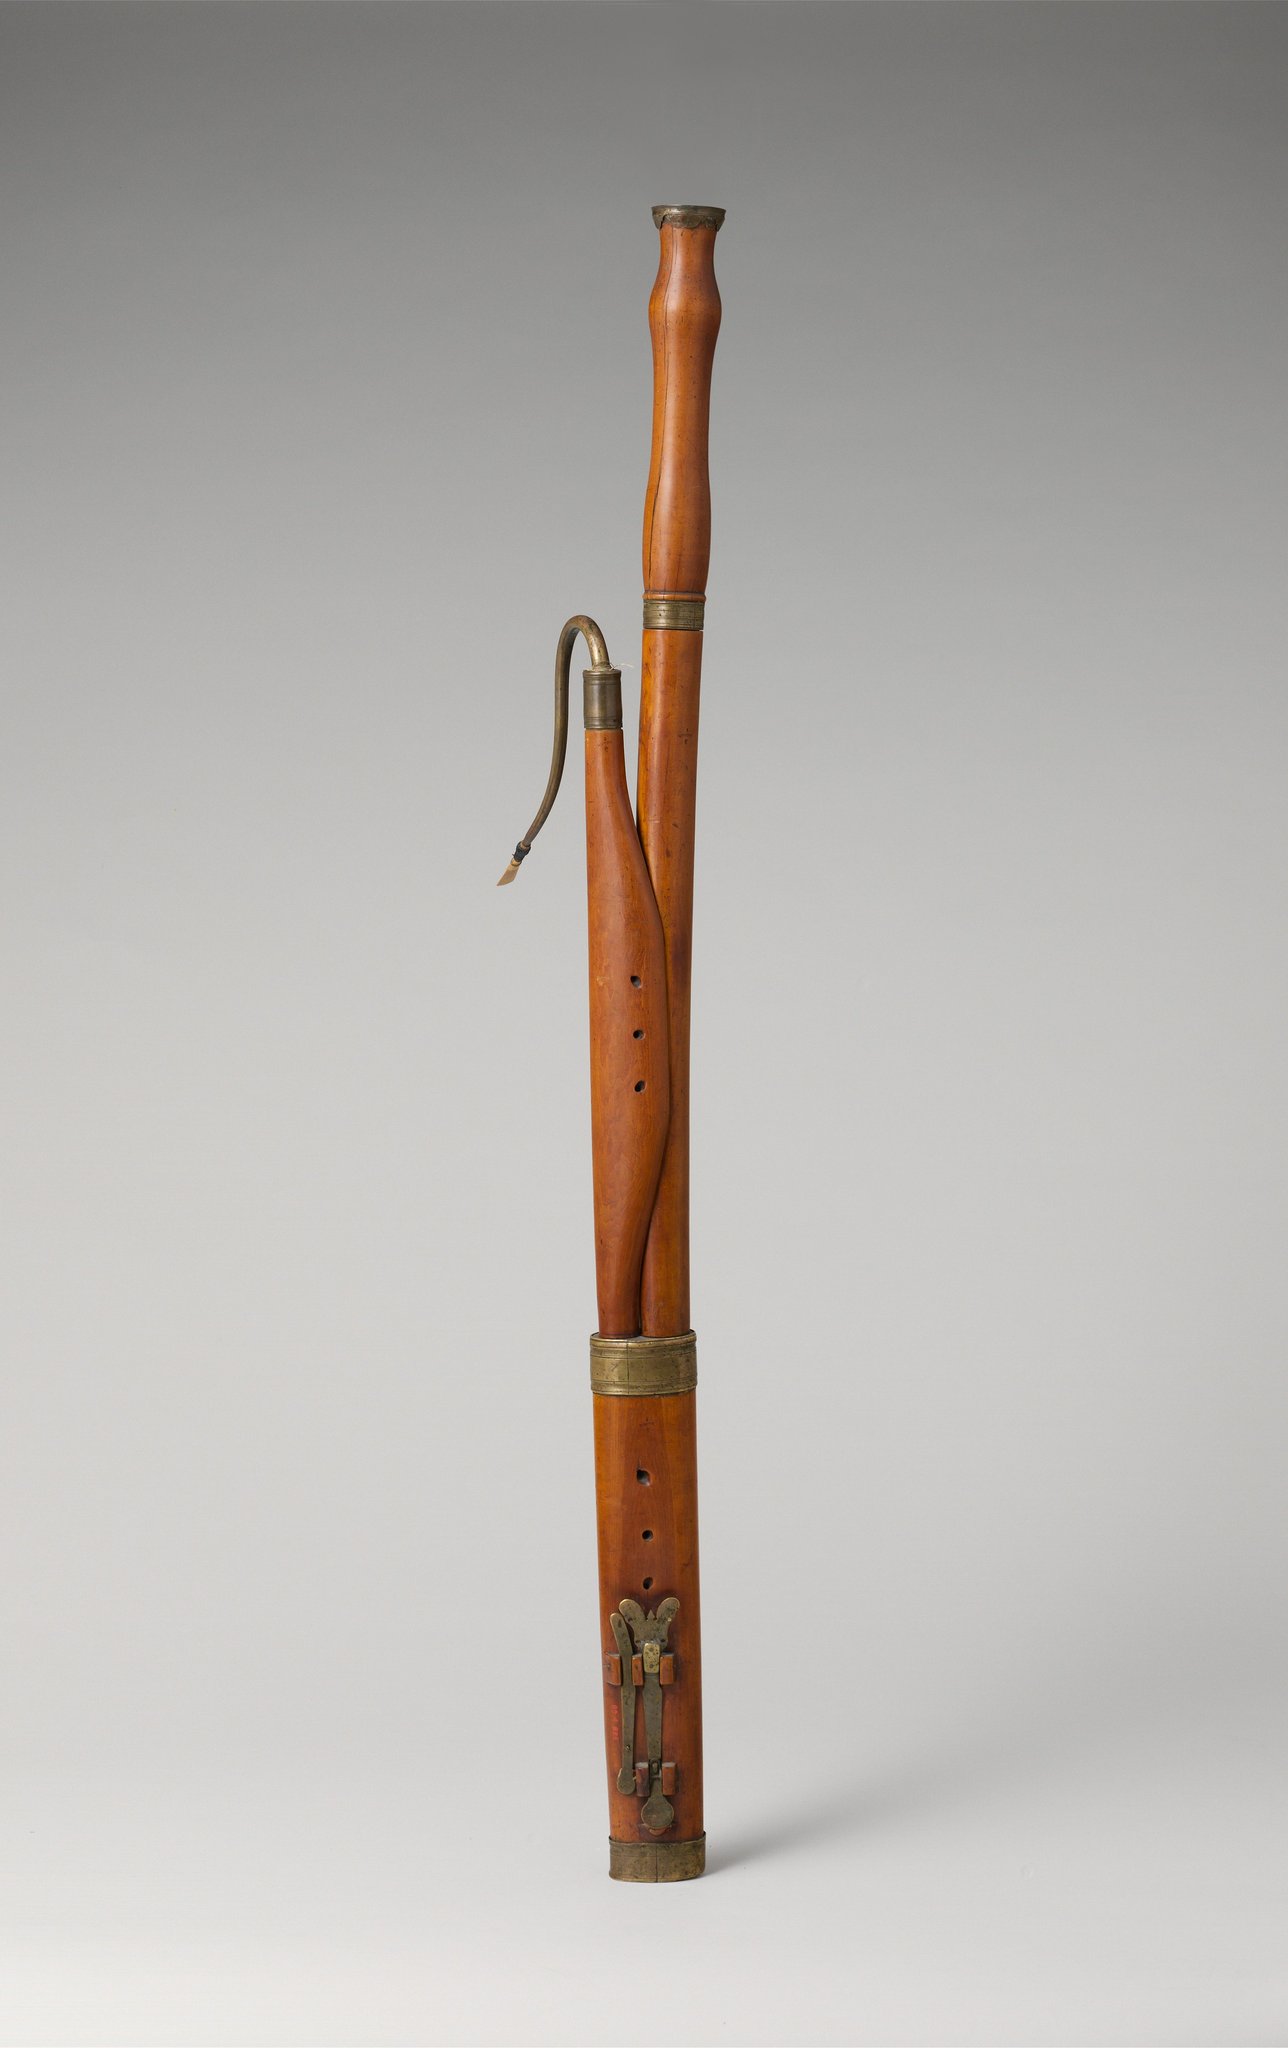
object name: bassoon in c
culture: german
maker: johannes scherer, jr.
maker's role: maker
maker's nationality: german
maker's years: 1664-1722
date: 1750-1770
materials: brass, wood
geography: germany